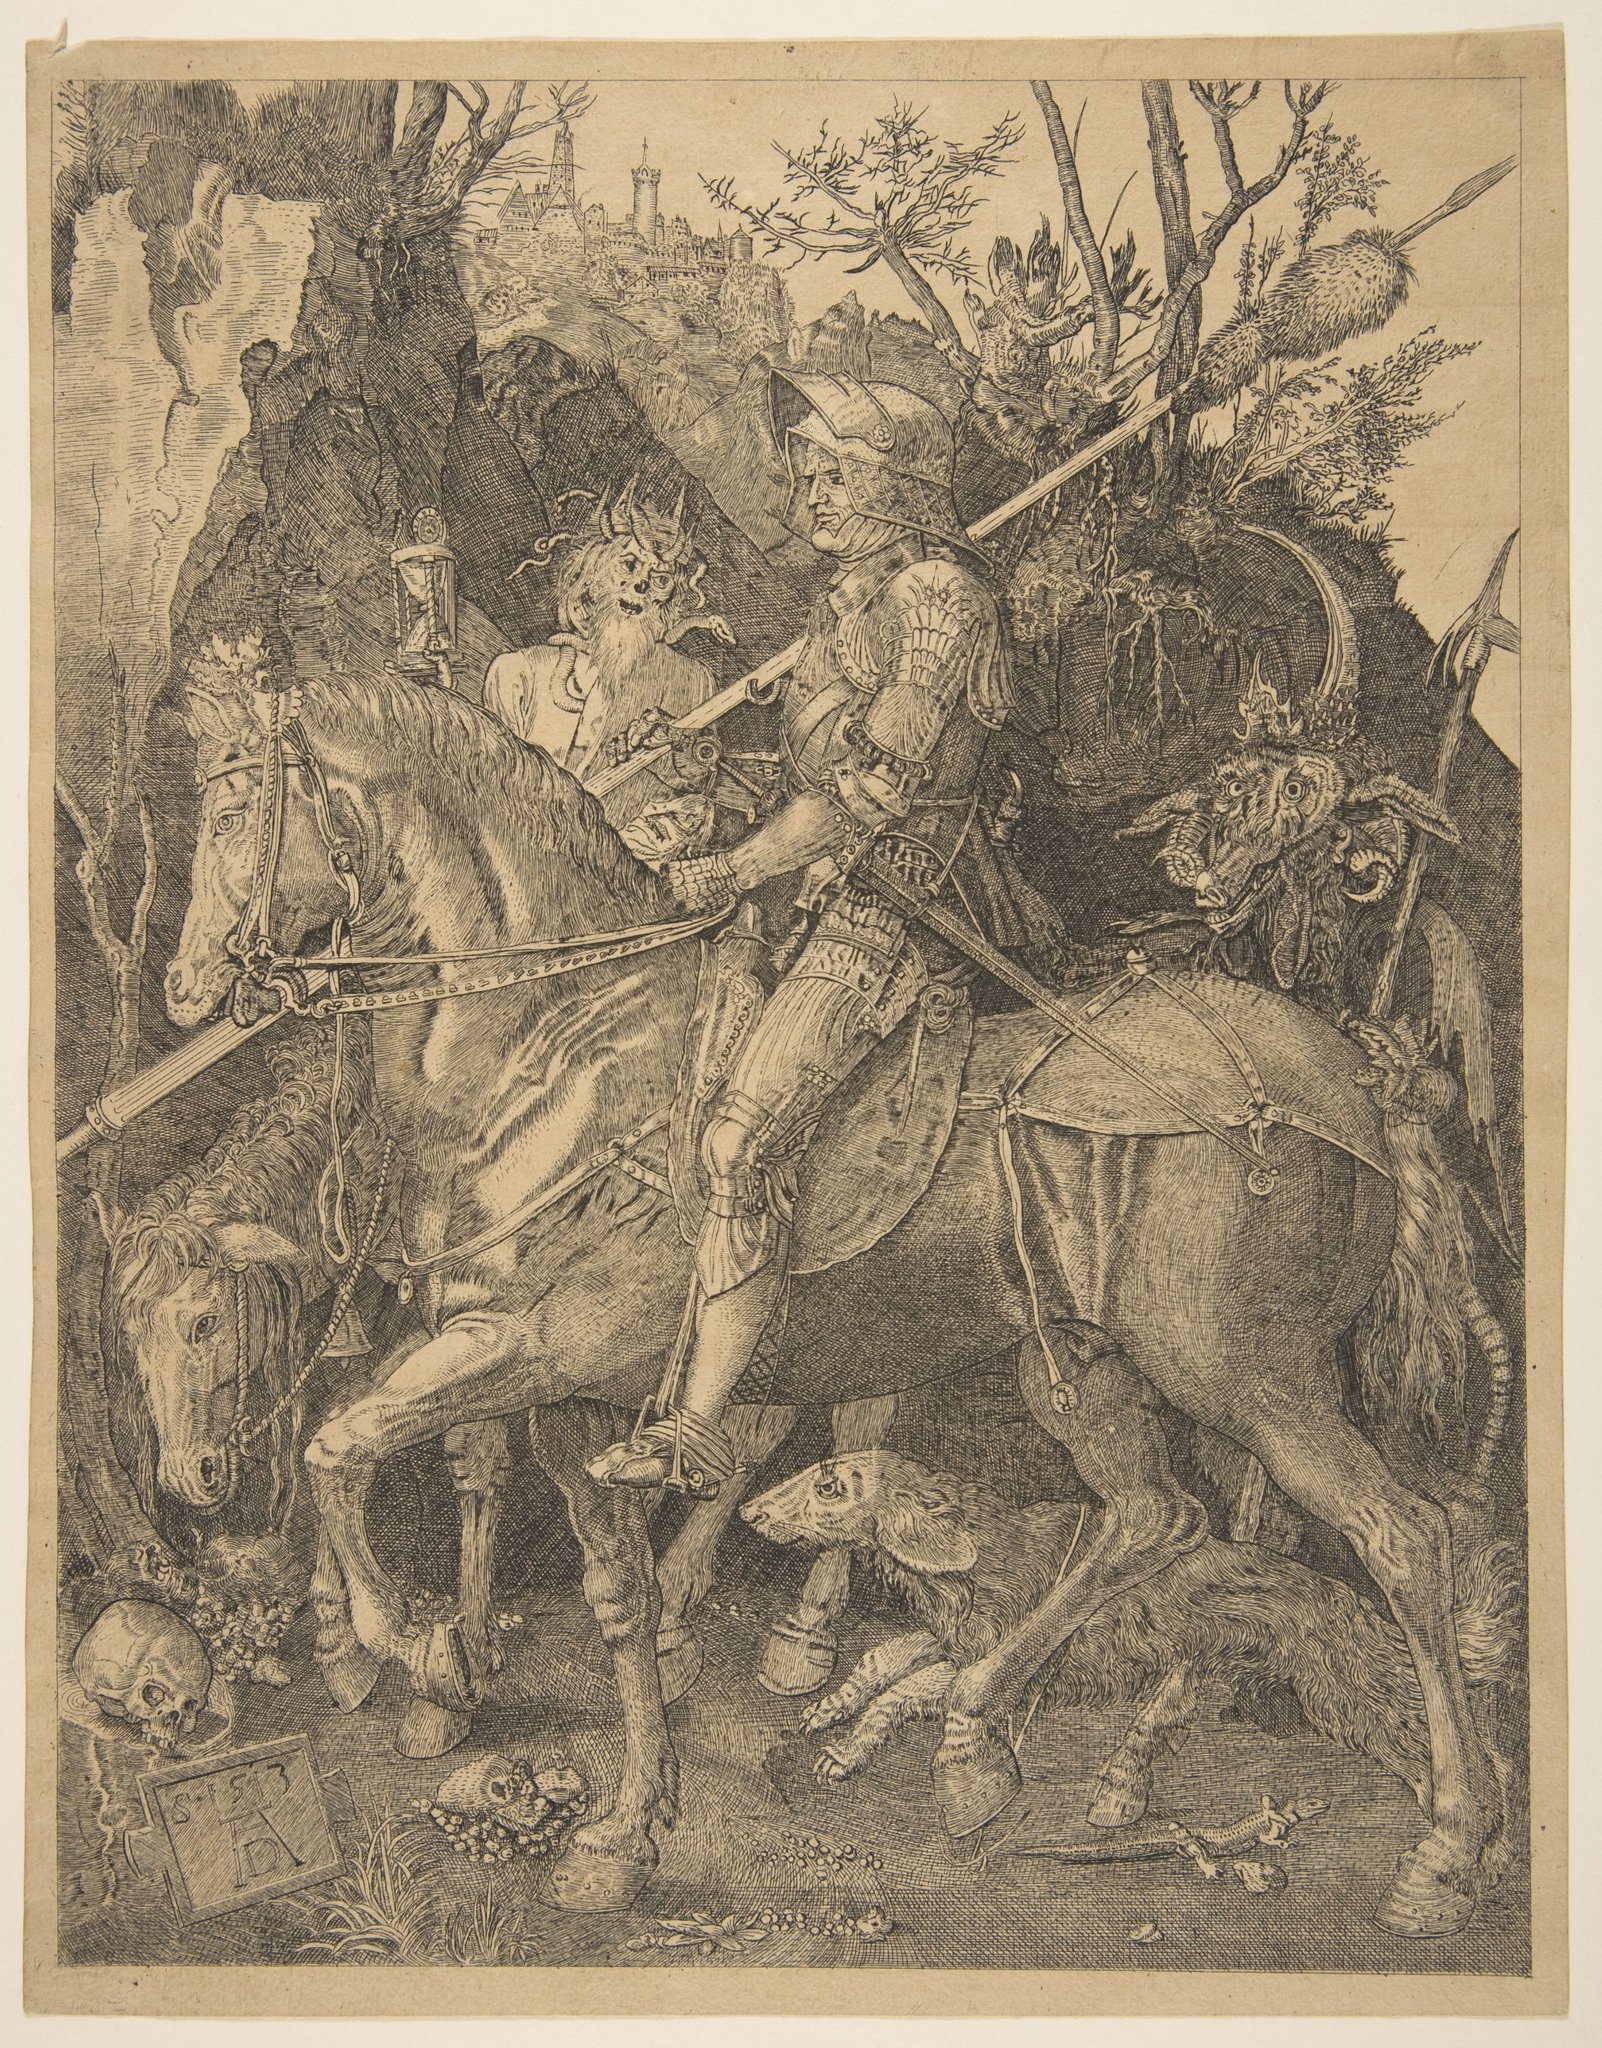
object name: print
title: Knight, Death, and the Devil (copy)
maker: albrecht dürer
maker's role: artist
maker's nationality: german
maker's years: 1471-1528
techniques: engraving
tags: animals,horses,devil,knights